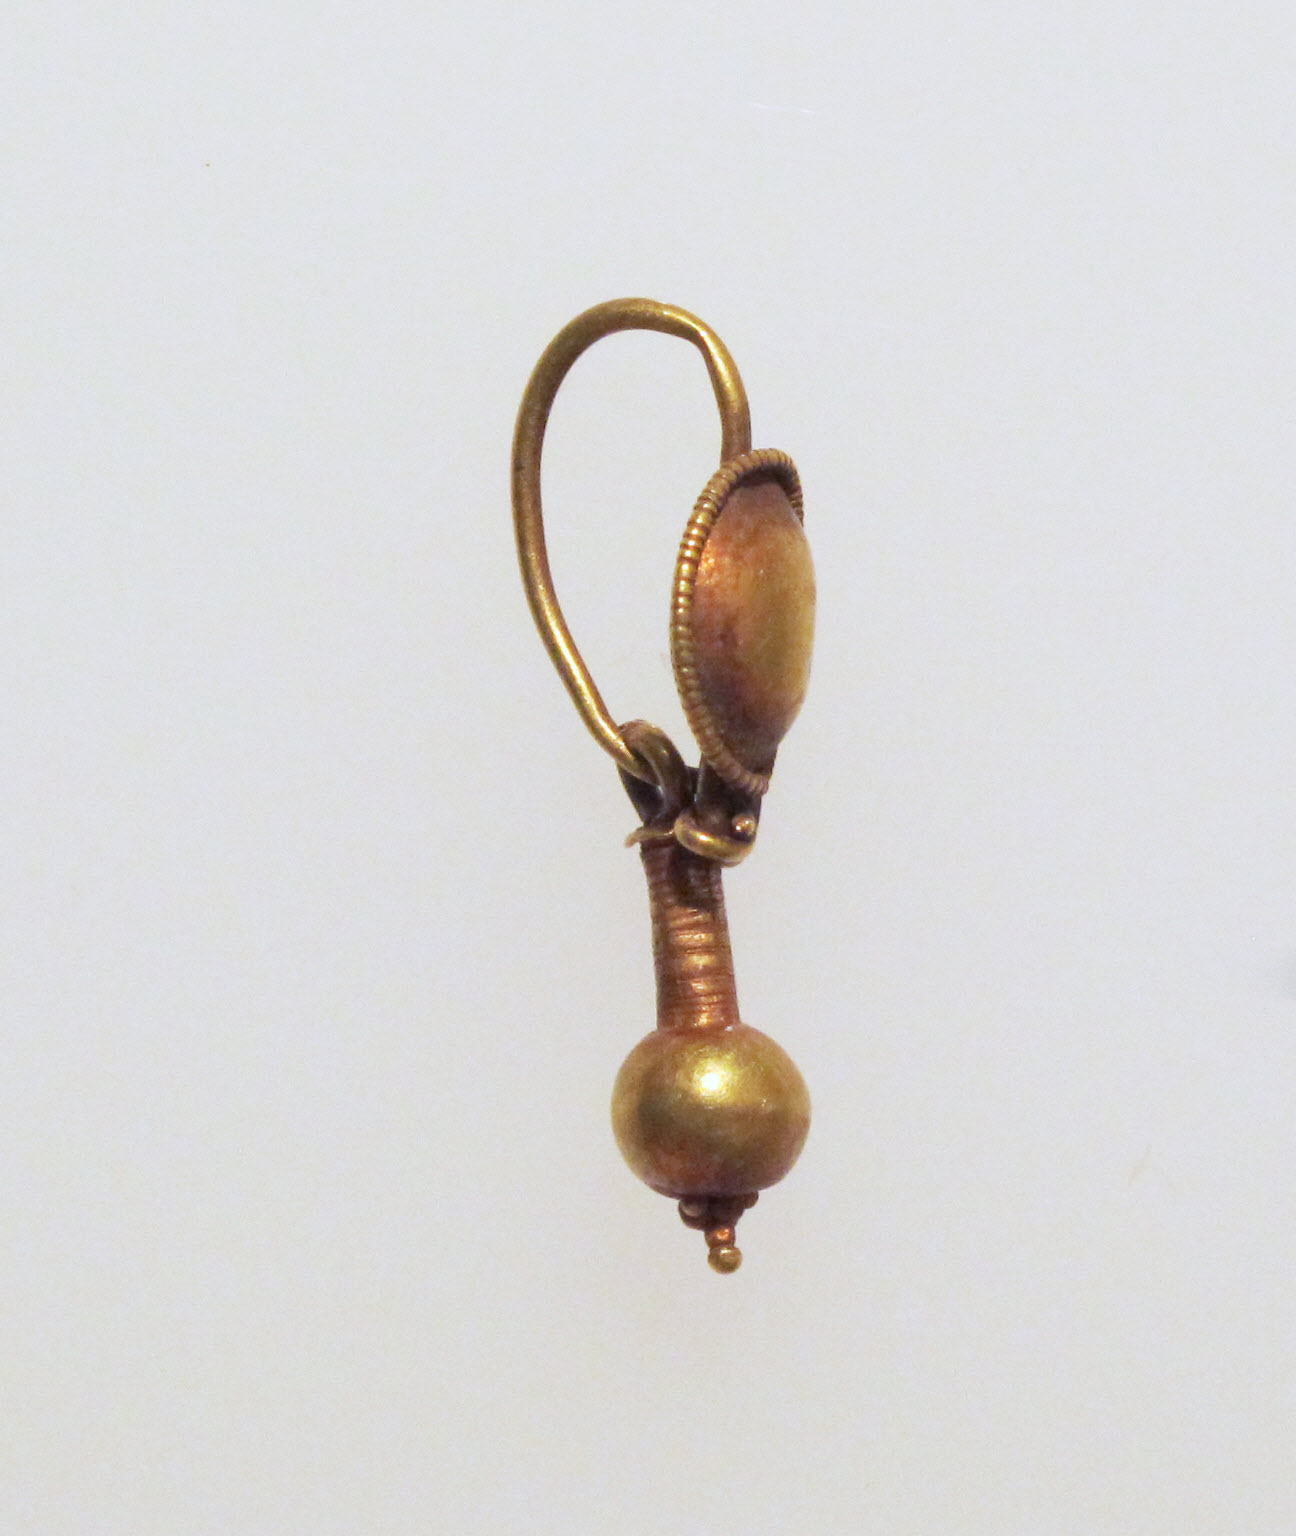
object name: earring with pendant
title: Gold earring with disc and pendant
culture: roman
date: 101-200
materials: gold